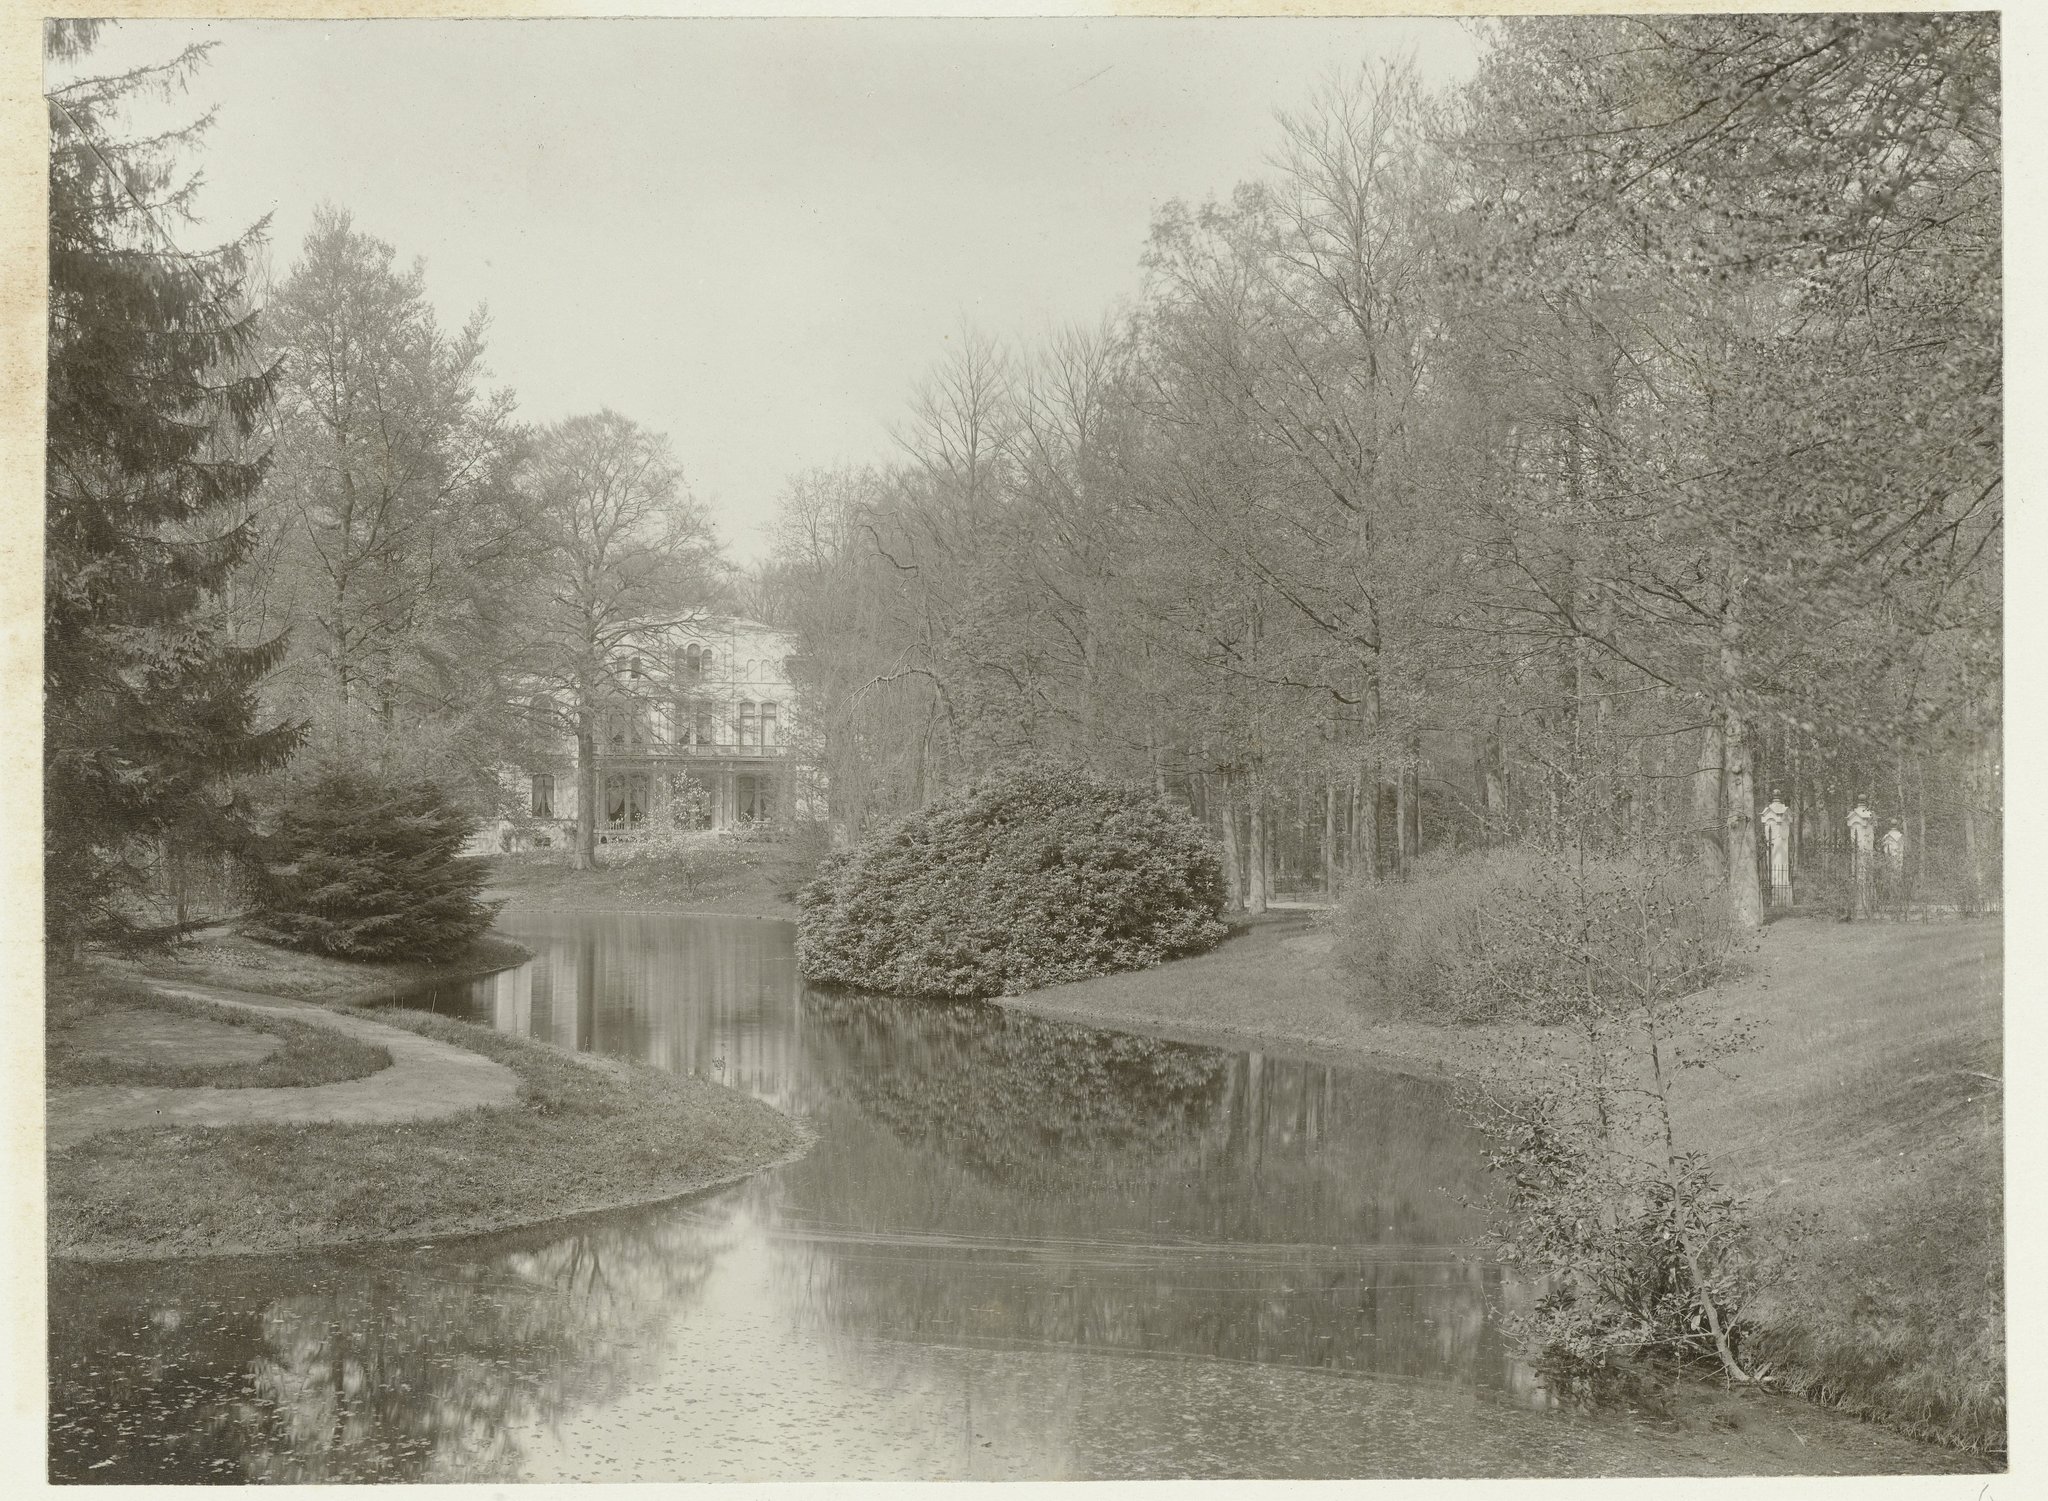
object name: photograph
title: Gezicht op landhuis De Wildbaan, Driebergen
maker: henry pauw van wieldrecht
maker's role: fotograaf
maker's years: 1863-1912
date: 1903-1907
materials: paper, photographic support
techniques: gelatin silver print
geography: netherlands